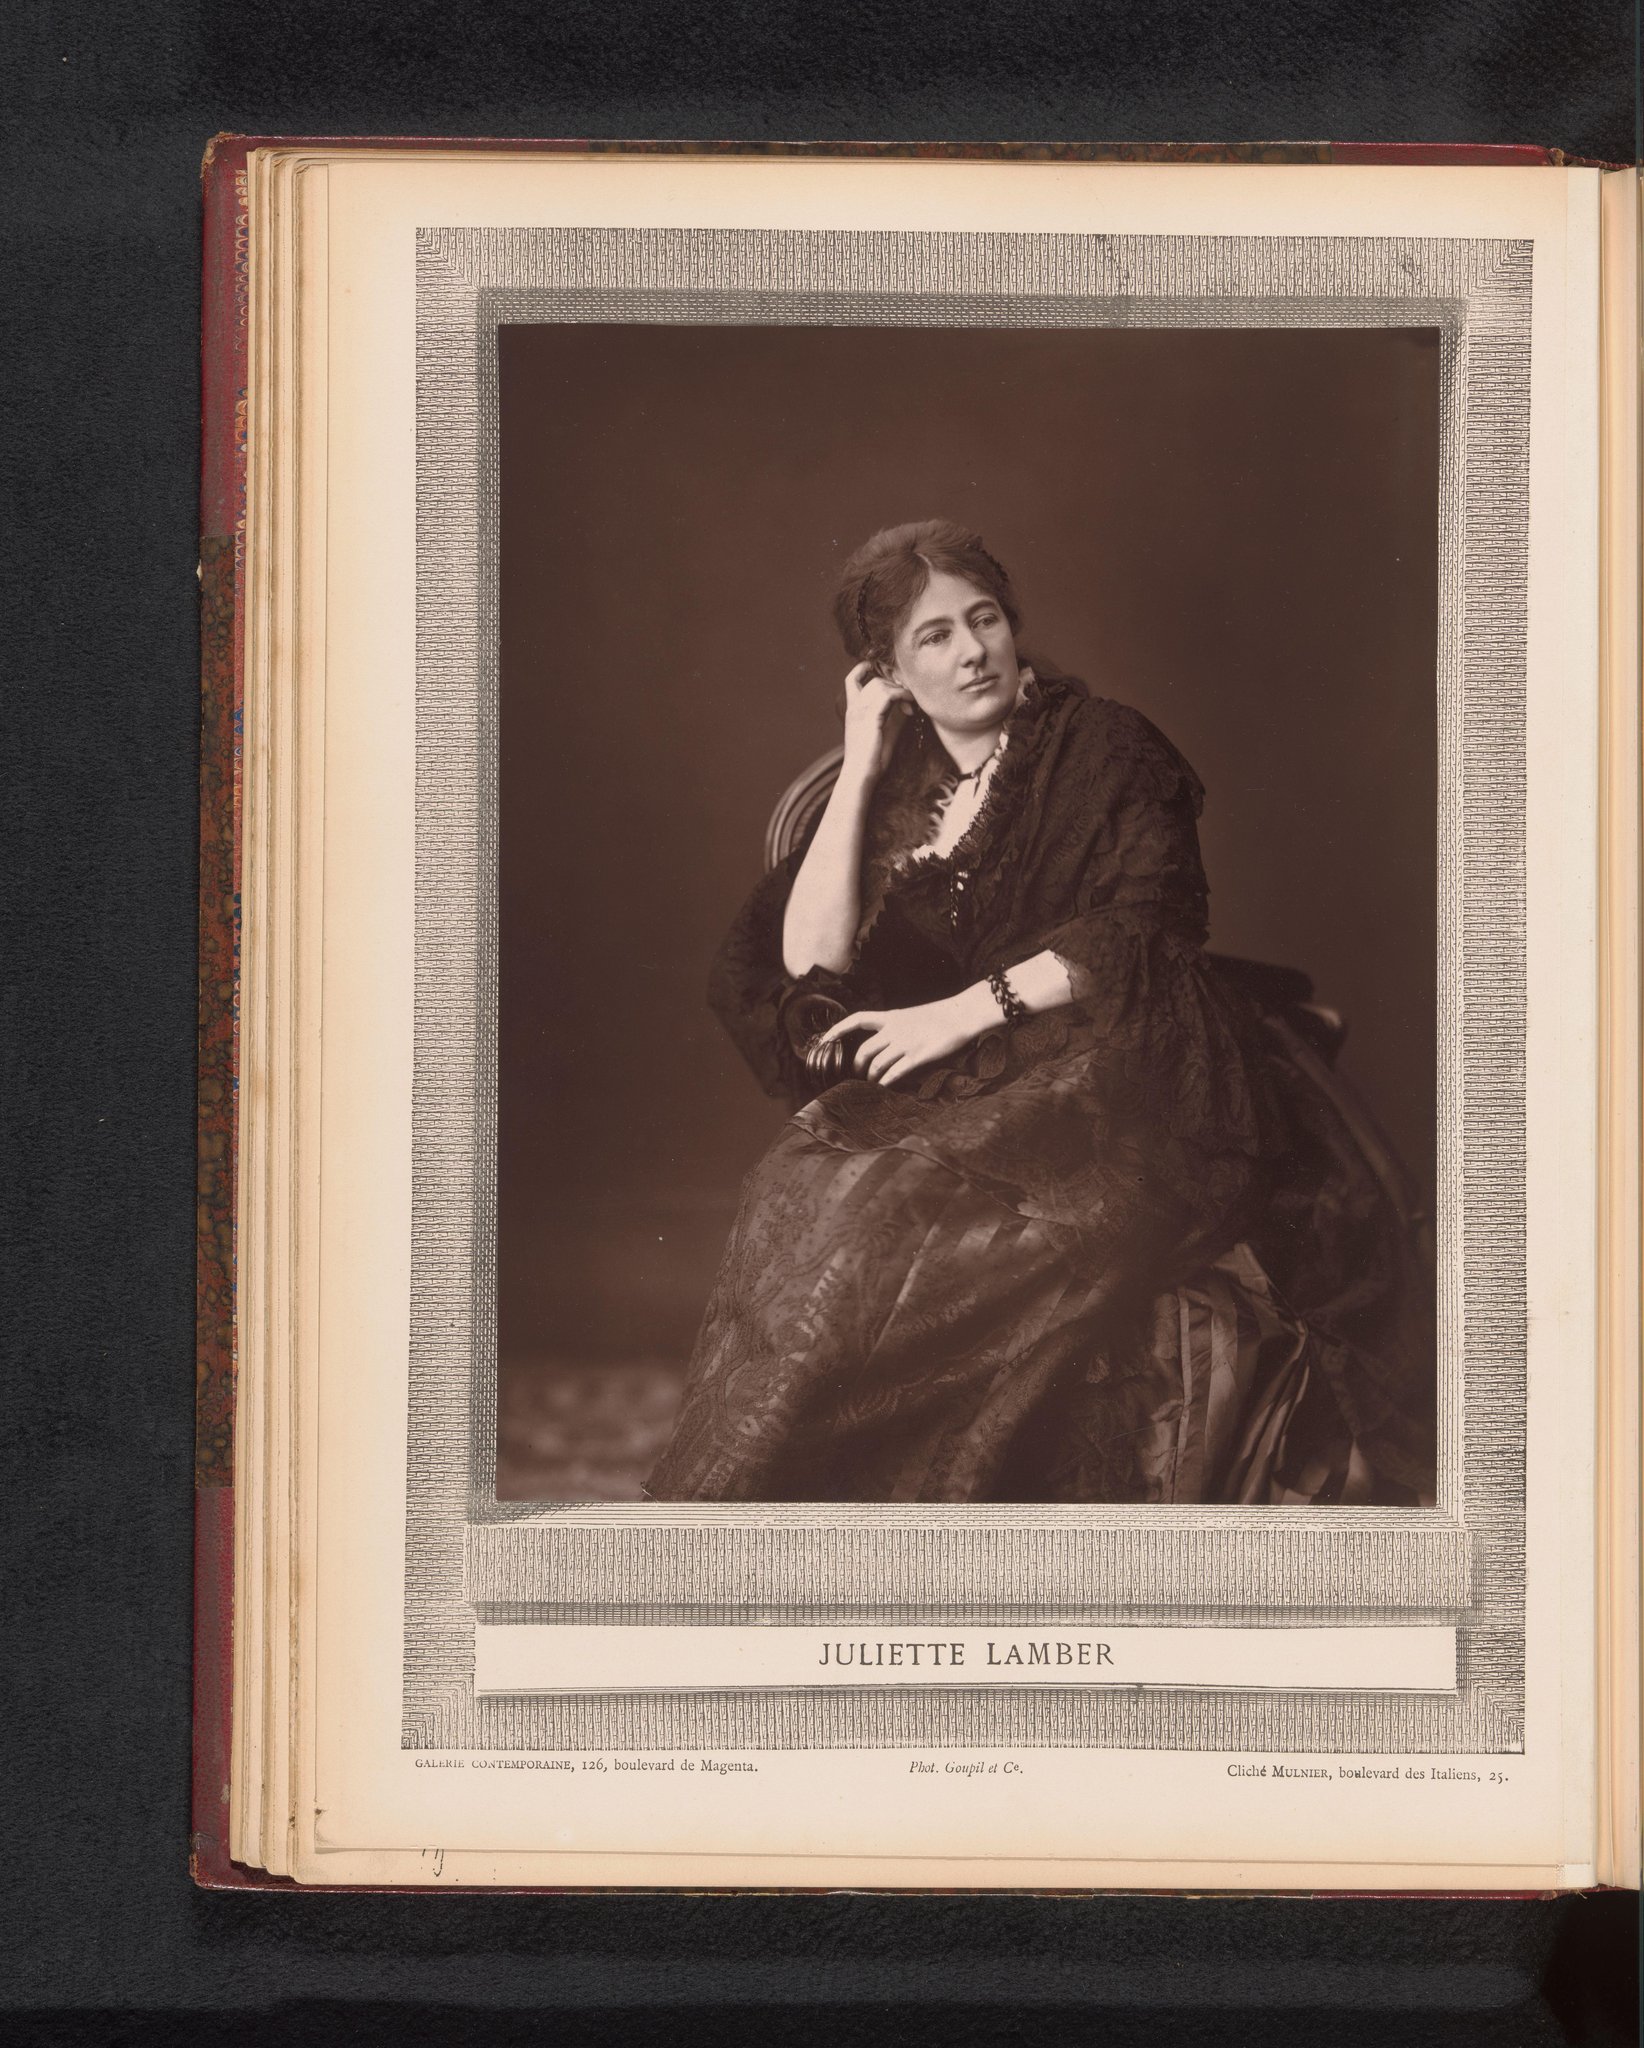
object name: page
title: Portret van Juliette Adam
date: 1872-1877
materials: paper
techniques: woodburytype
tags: adult woman, historical persons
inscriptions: inscription: ‘Galerie Contemporaine, 126, boulevard de Magenta.’